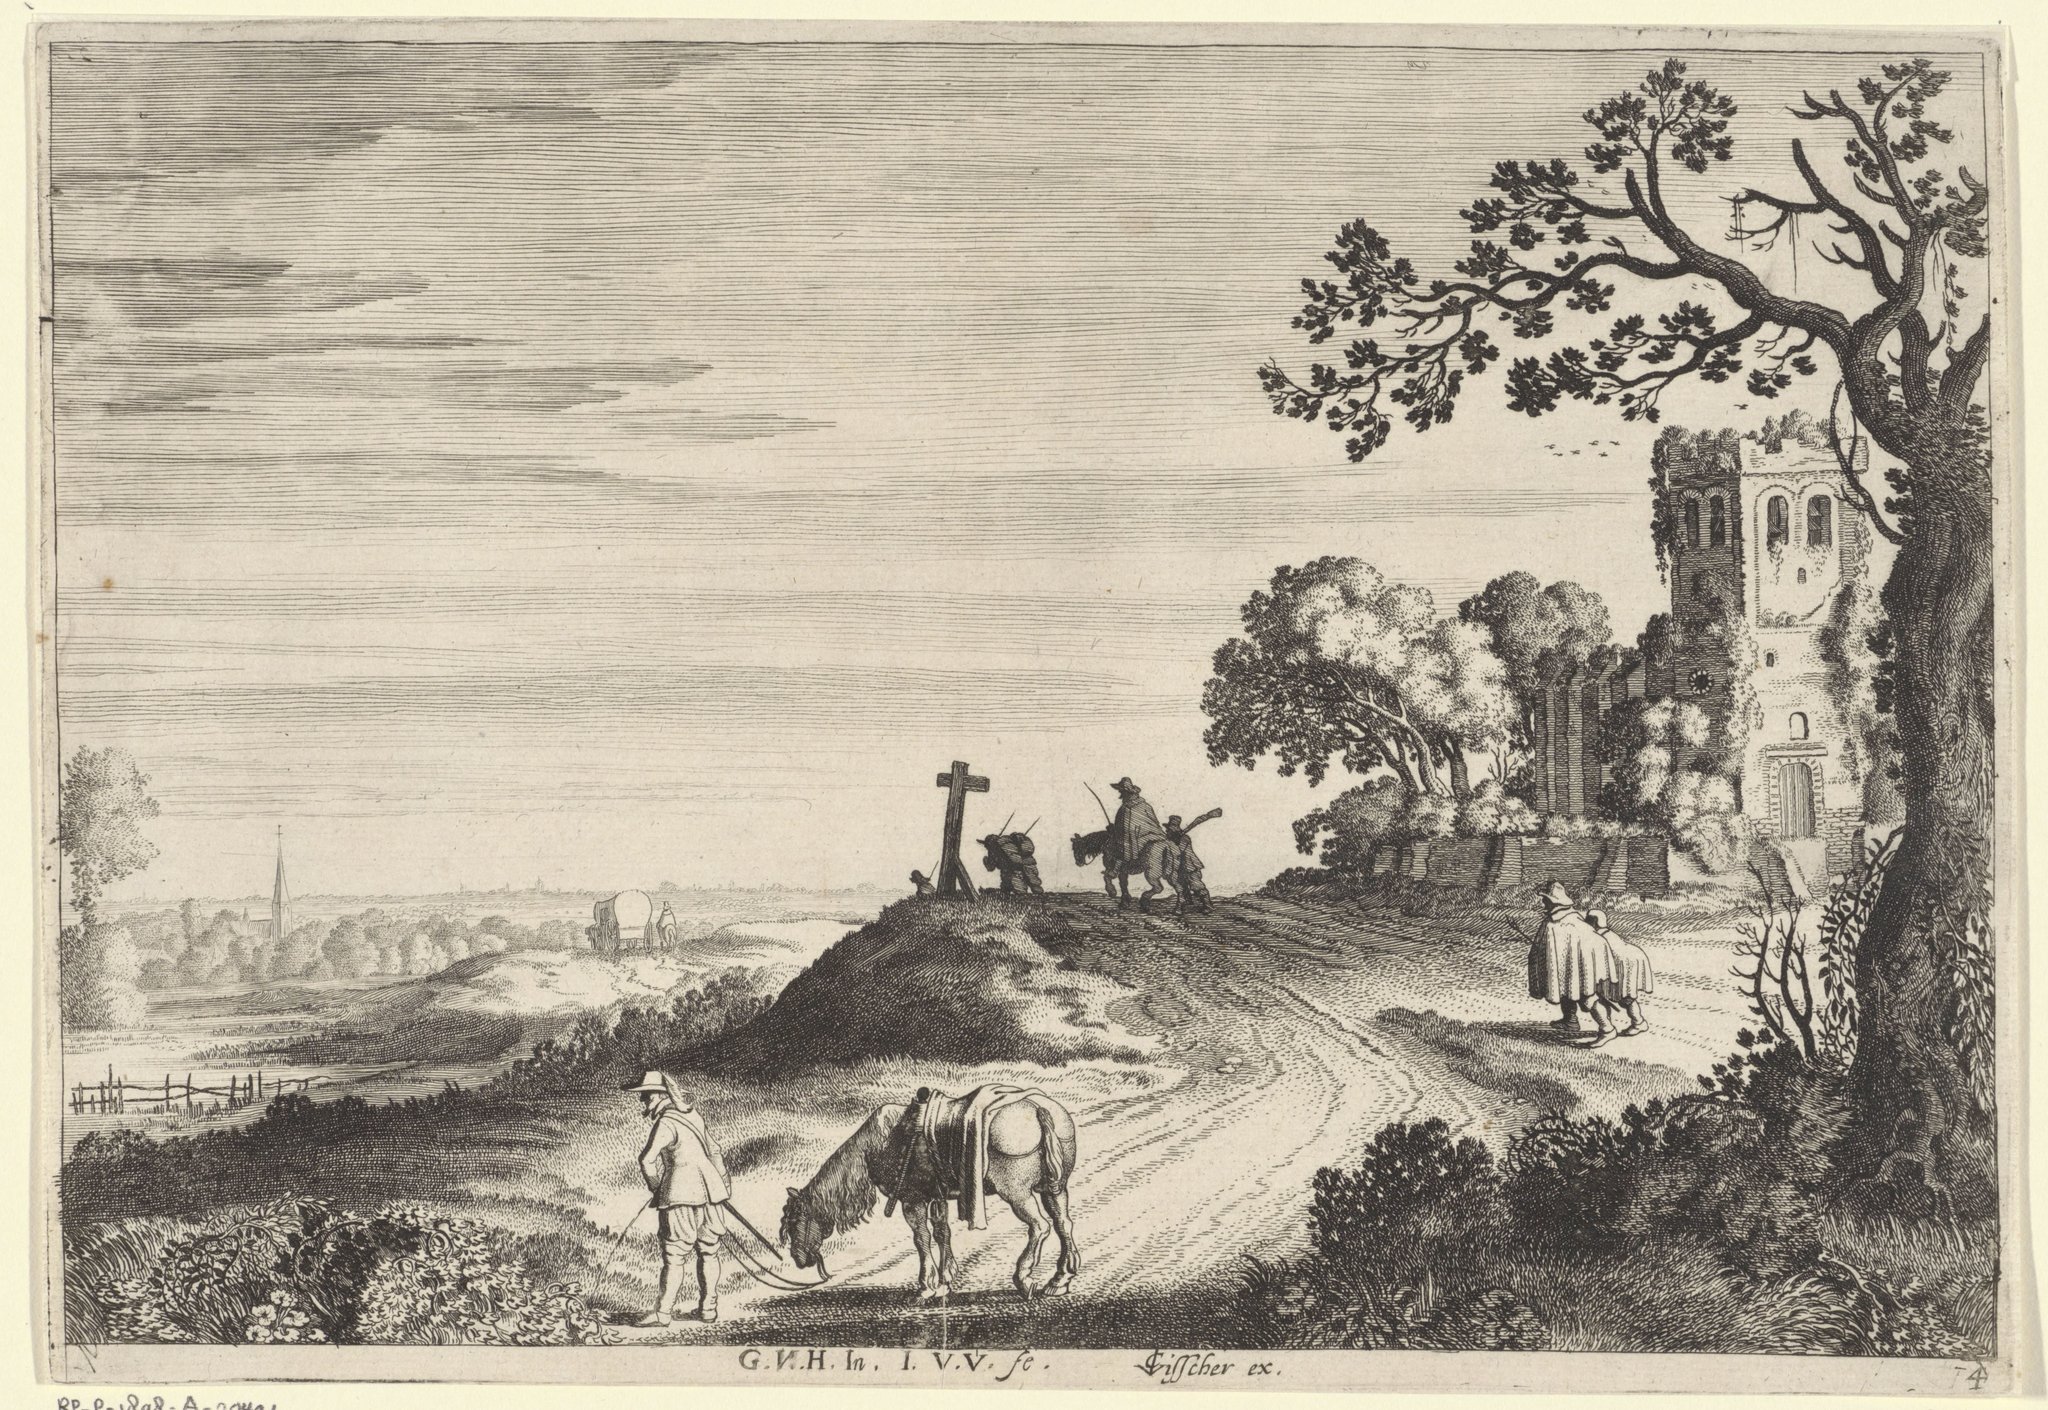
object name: print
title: Landweg langs ruïne van een kerk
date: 1628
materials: paper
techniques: etching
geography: northern netherlands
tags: ruin of church, monastery, etc., covered wagon, hooded wagon, leading a horse by the reins; rider beside his horse, urination, 'en route', traveller under way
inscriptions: collector's mark: Lugt 964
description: Claes Jansz. Visscher (II) heeft een zesde prent, gemaakt door hemzelf en tevens naar ontwerp van Gerrit van der Horst, aan de serie toegevoegd. Franken & Van der Kellen noemt deze prent de zesde prent van deze serie, Hollstein noemt deze zesde prent maar voegt hem niet toe aan de serie van Van de Velde (II).